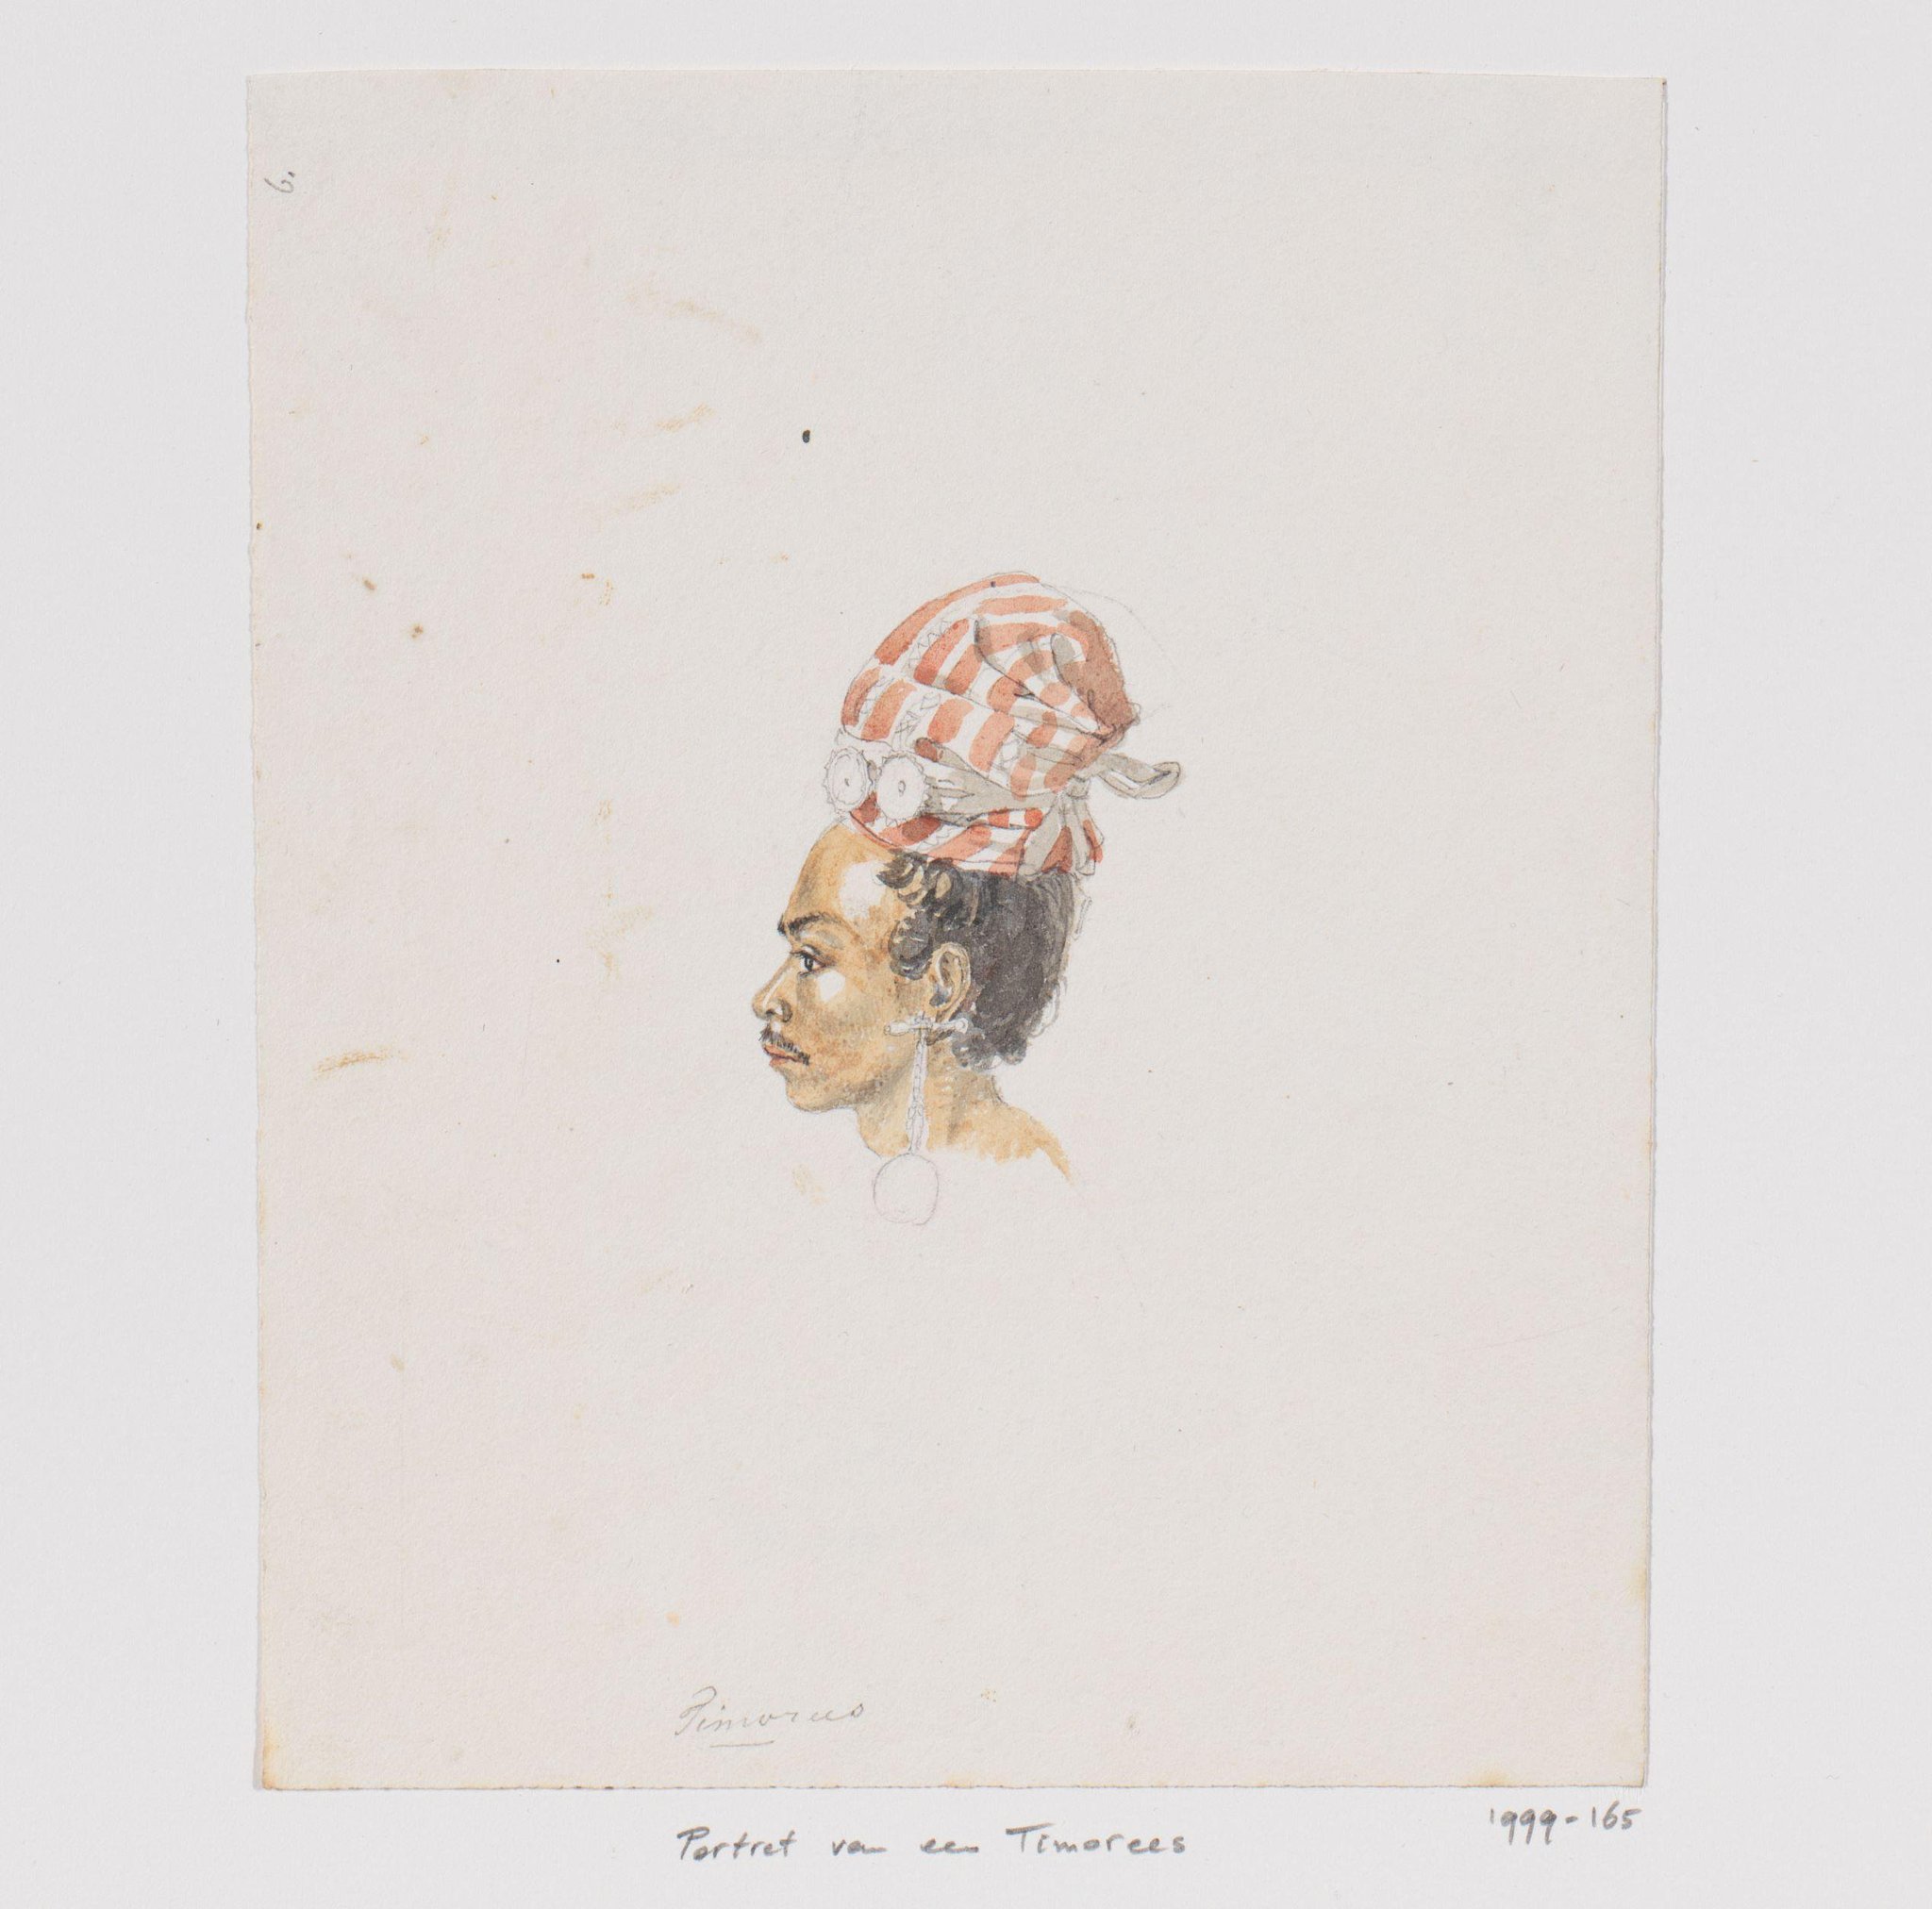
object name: drawing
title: Portret in profiel van een Timorees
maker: adrianus johannes bik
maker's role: draughtsman, print maker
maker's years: 1790-1872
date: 1821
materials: paper, pencil, watercolor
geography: timor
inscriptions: annotation: ‘Timorees’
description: soortgelijke Timorees gelithografeerd naar een tekening van A.J. Bik en afgebeeld in Vriese 1858, t./o. p. 346, litho nr.V. artikel over deze collectie in Bulletin van het Rijksmuseum 49 [2001], nr. 4, pp.343 e.v.: Vriese 1858, afb. t/o. p.346, litho nr. V